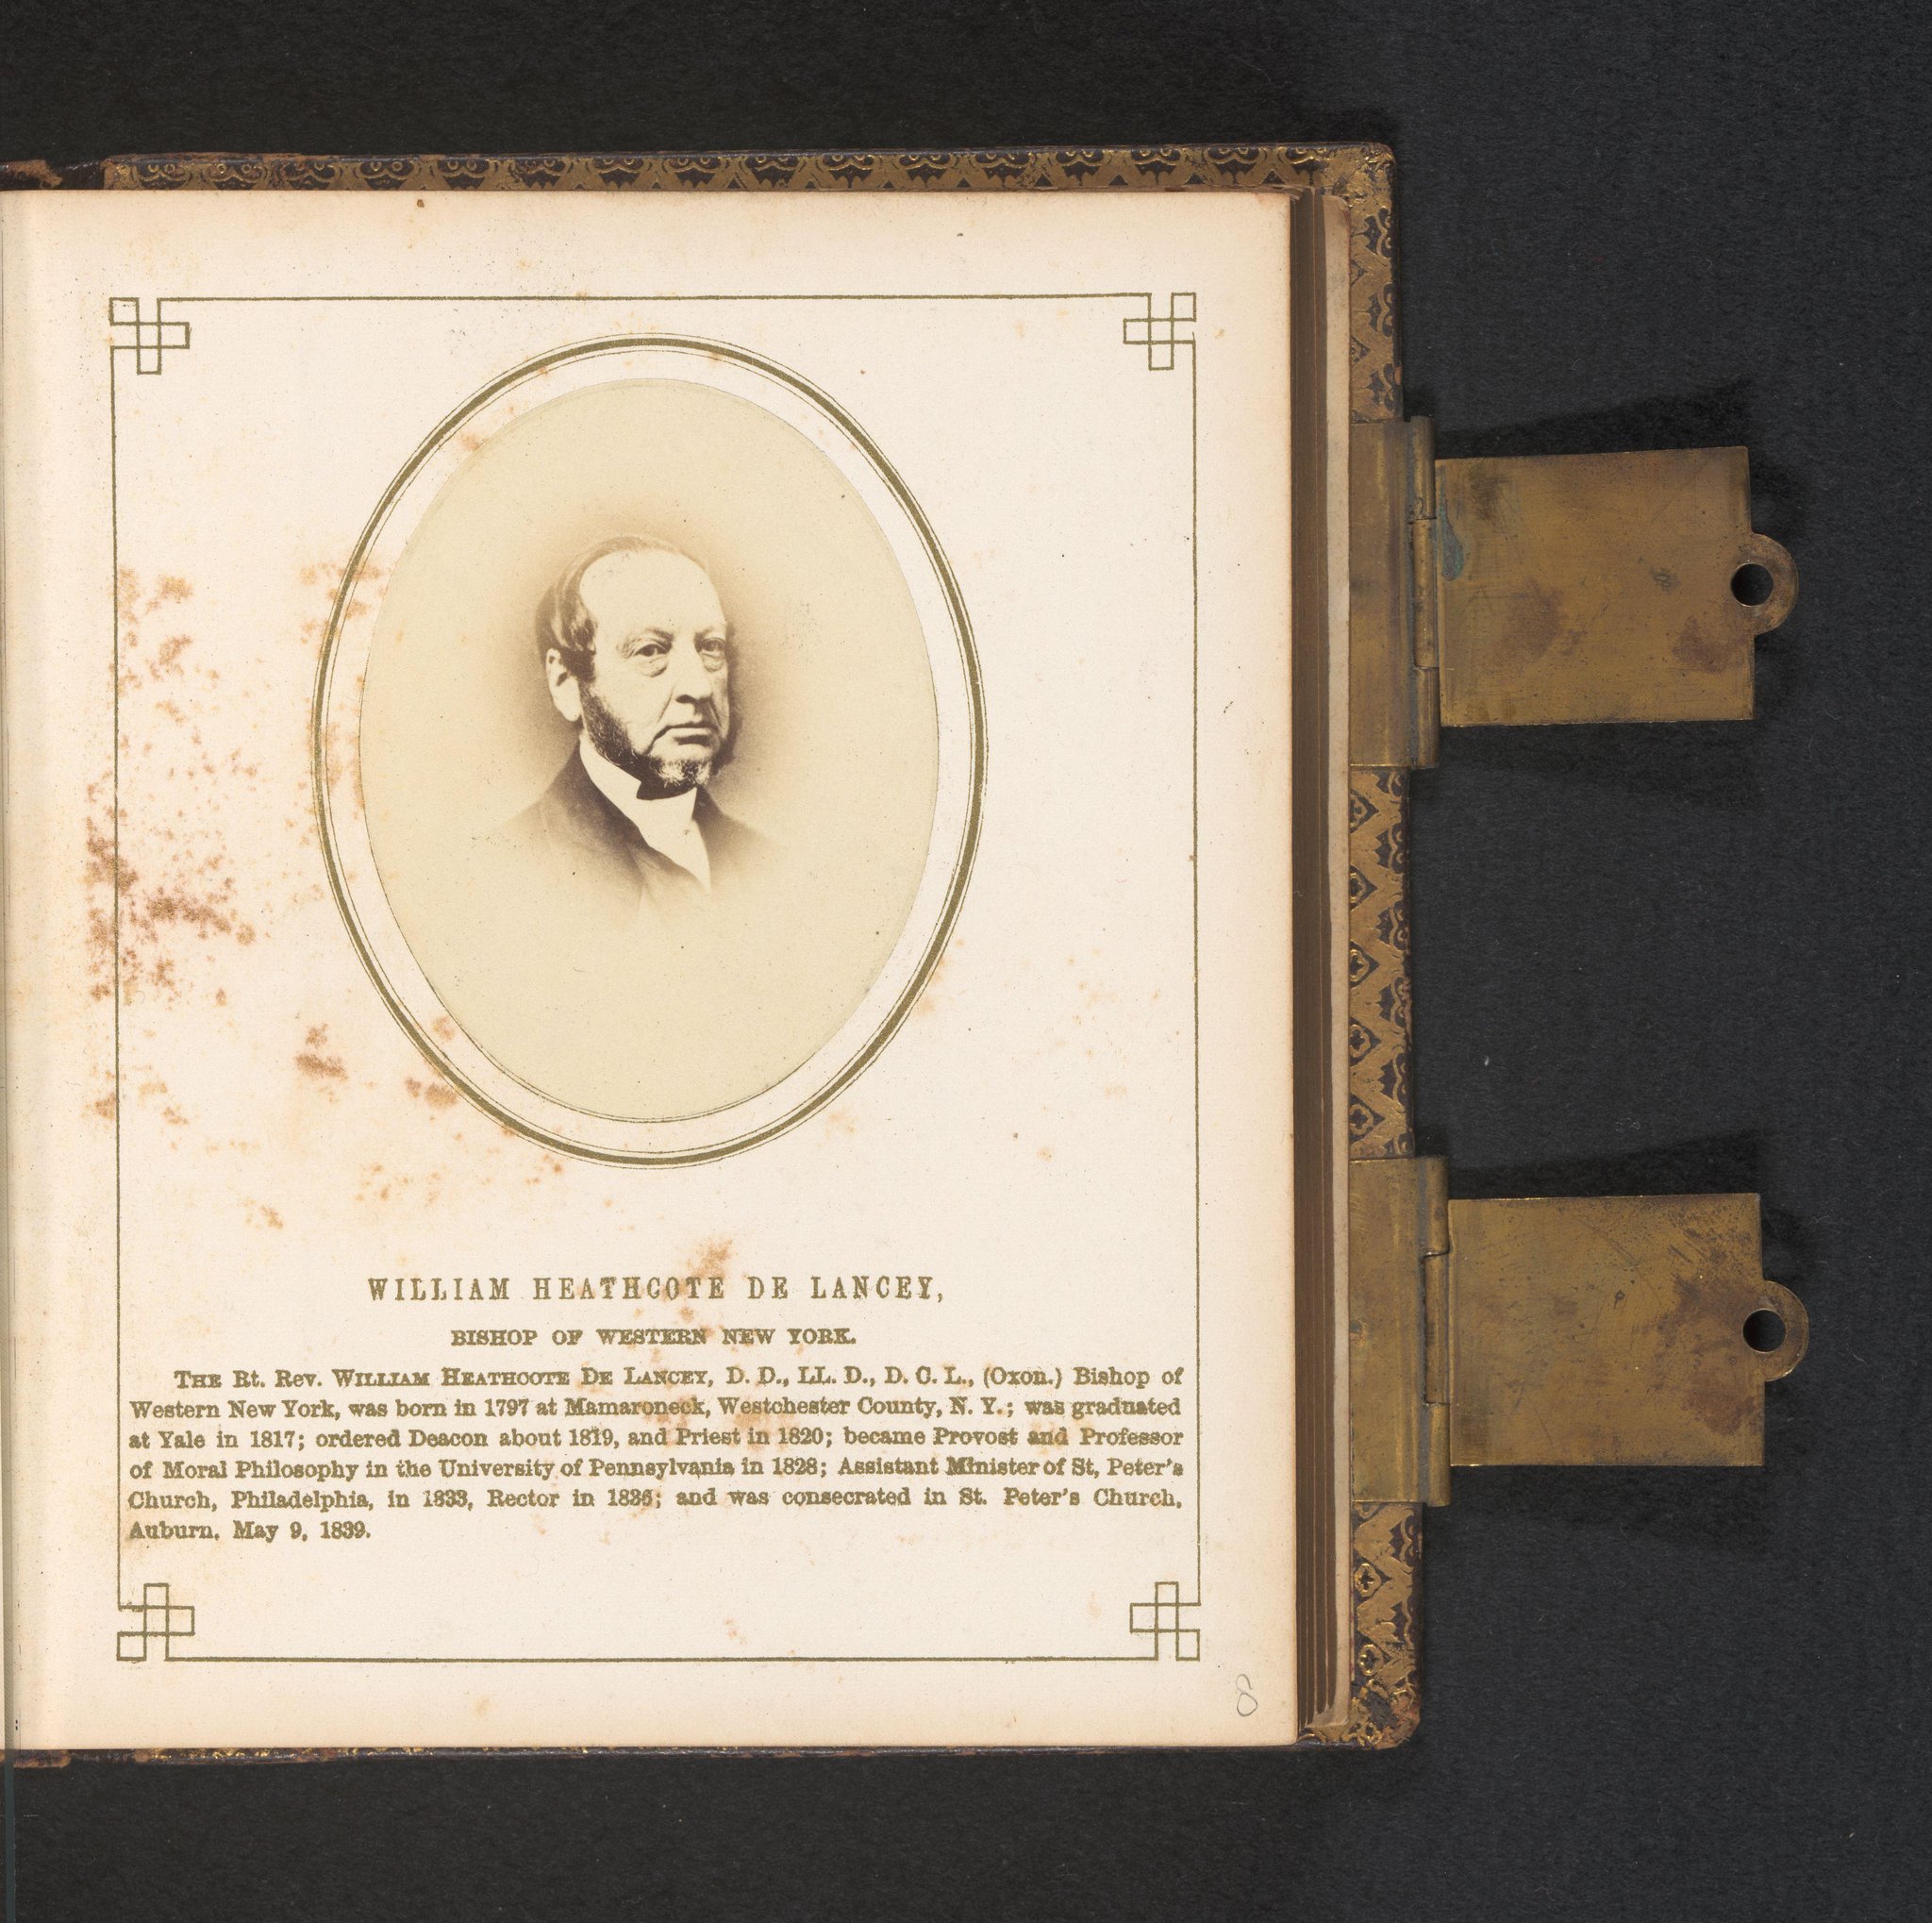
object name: photograph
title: Portret van William Heathcombe De Lancey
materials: photographic support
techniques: albumen print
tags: historical persons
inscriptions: inscription: ‘William Heathcombe De Lancey/ Bishop of Western New York (...)’